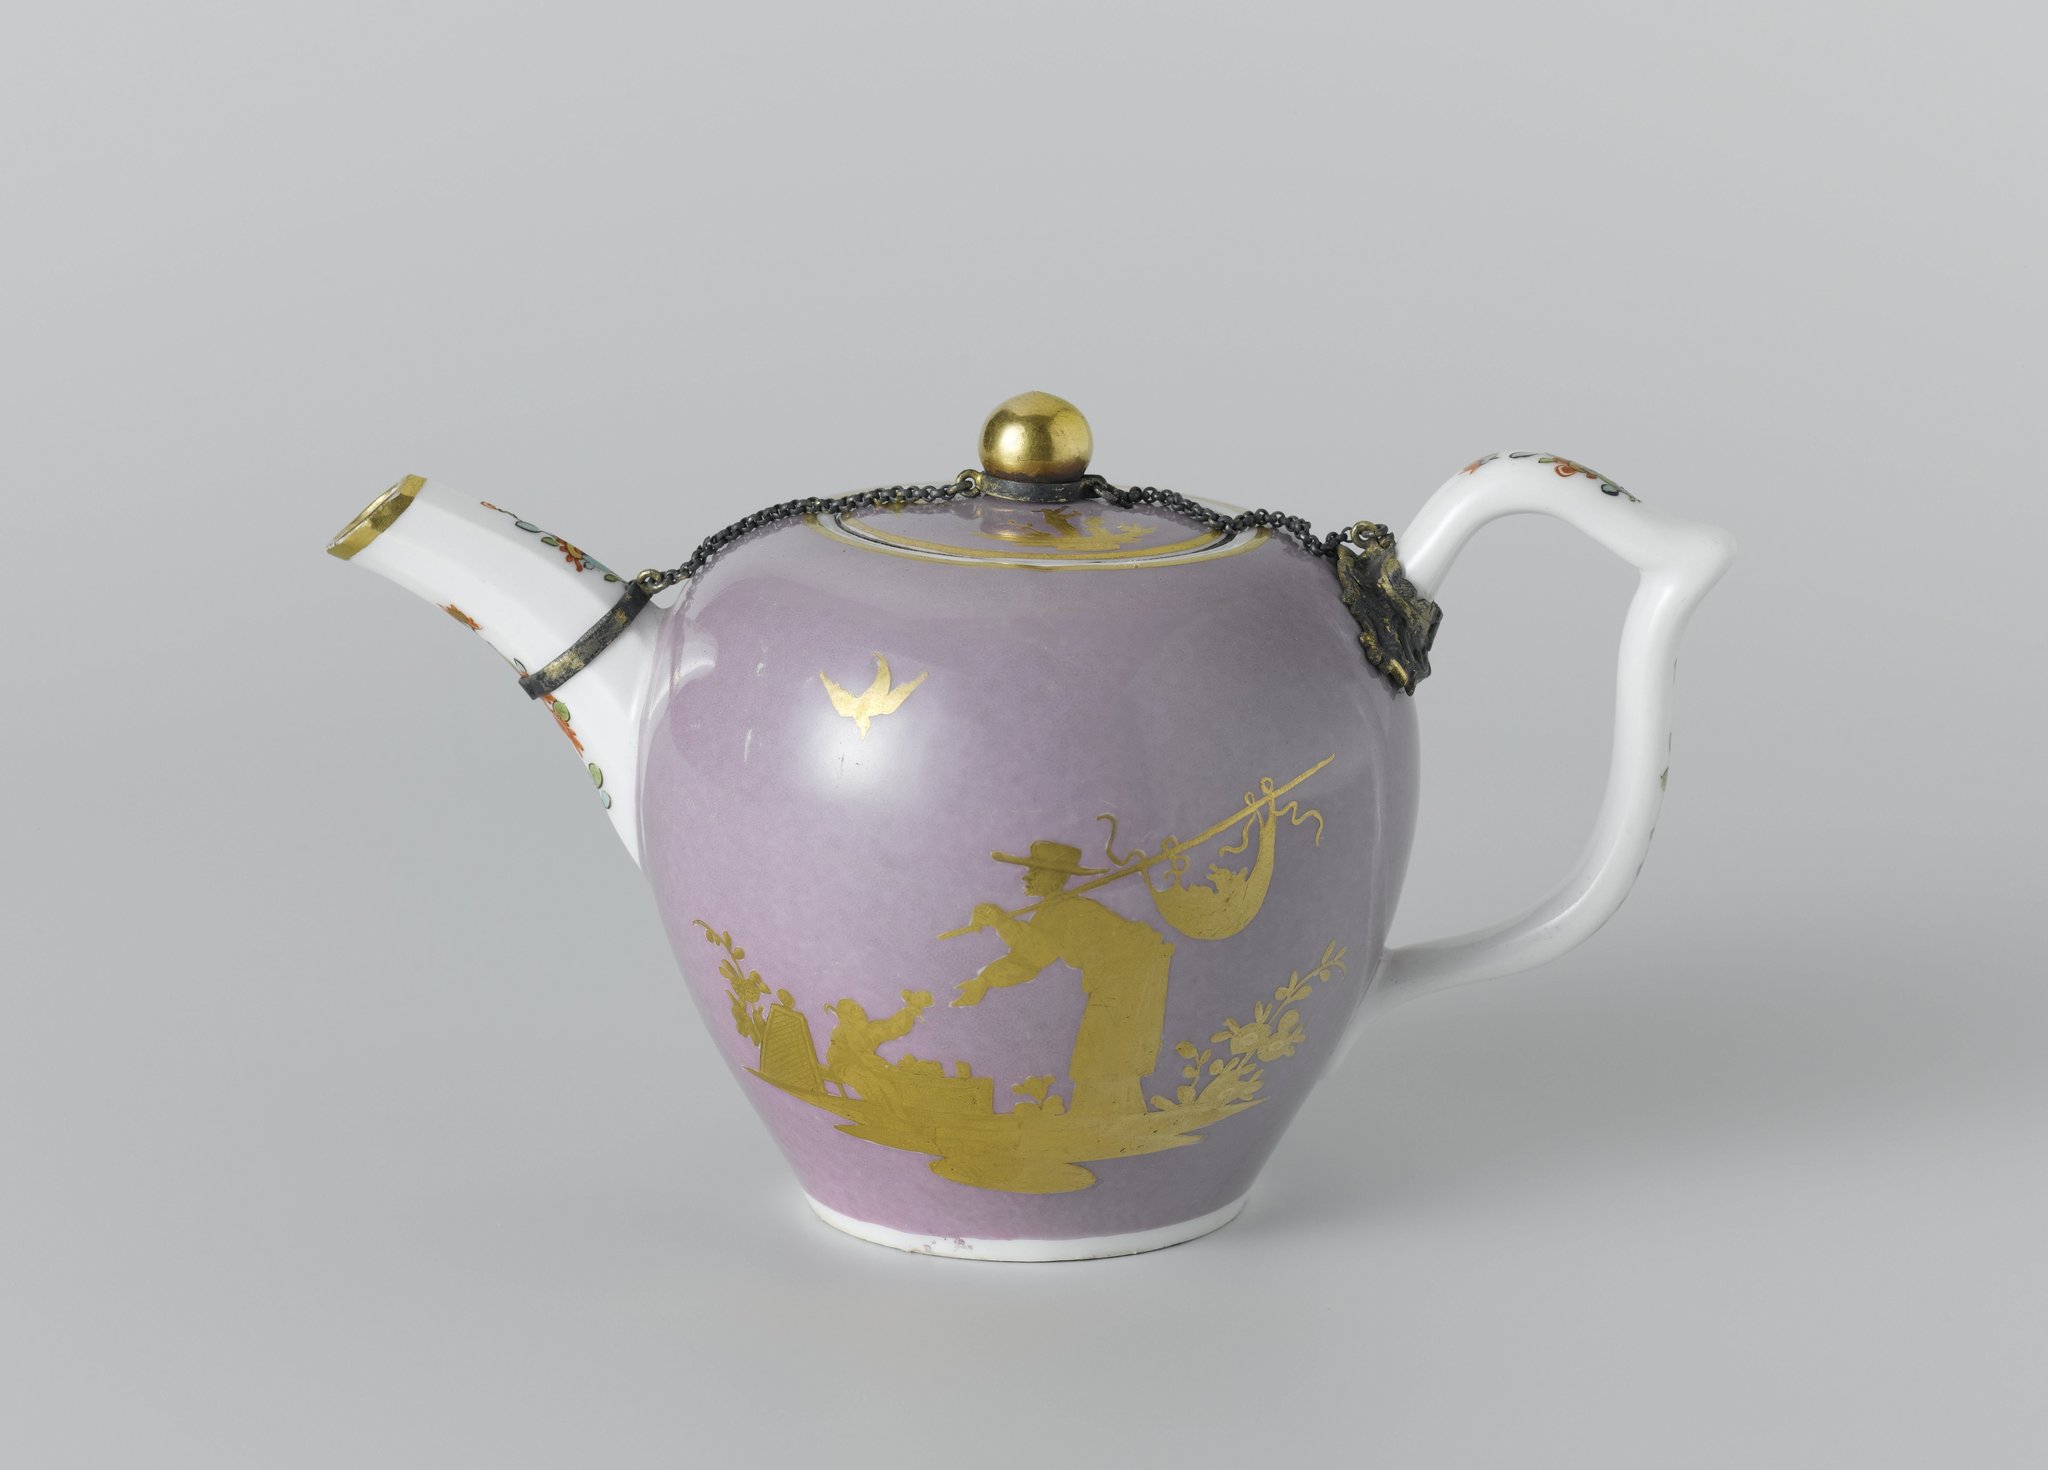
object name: teapot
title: Lidded teapot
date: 1730-1735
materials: porcelain, silver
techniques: gilding, painted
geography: meissen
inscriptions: factory mark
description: Meissener Porzellan Manufaktur Meissen, c. 1730–1735 hard-paste porcelain, silver